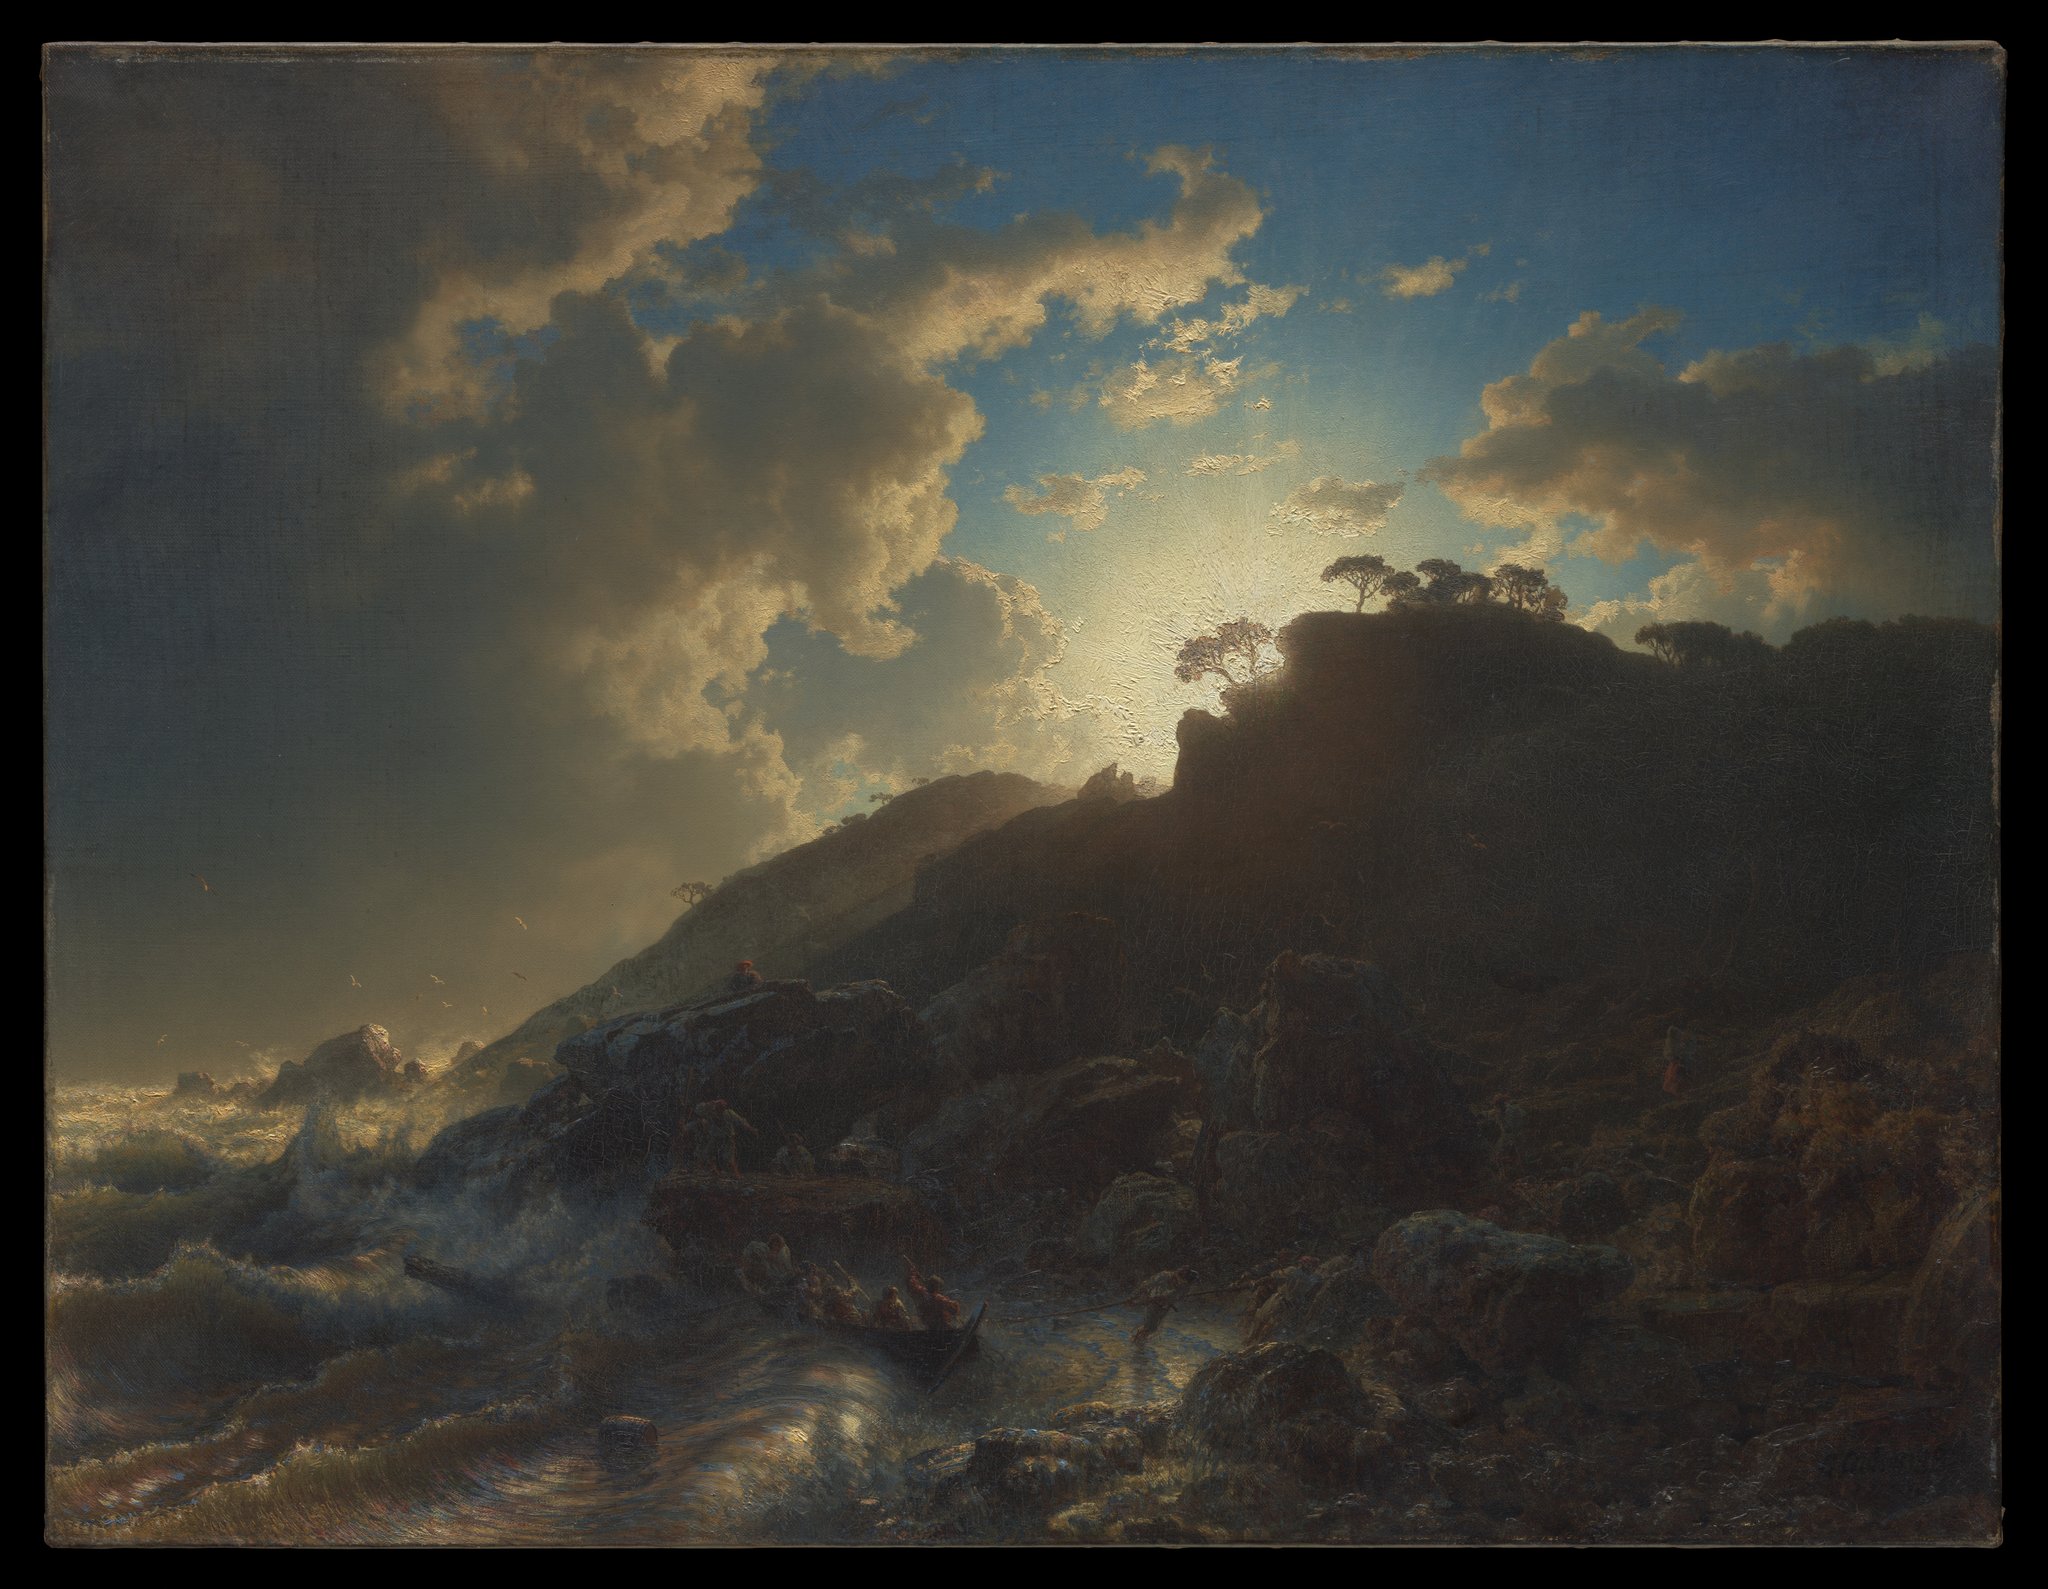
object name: painting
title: Sunset after a Storm on the Coast of Sicily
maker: andreas achenbach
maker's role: artist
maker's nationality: german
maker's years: 1815-1910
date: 1853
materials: canvas, oil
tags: seas,landscapes,evening,boats